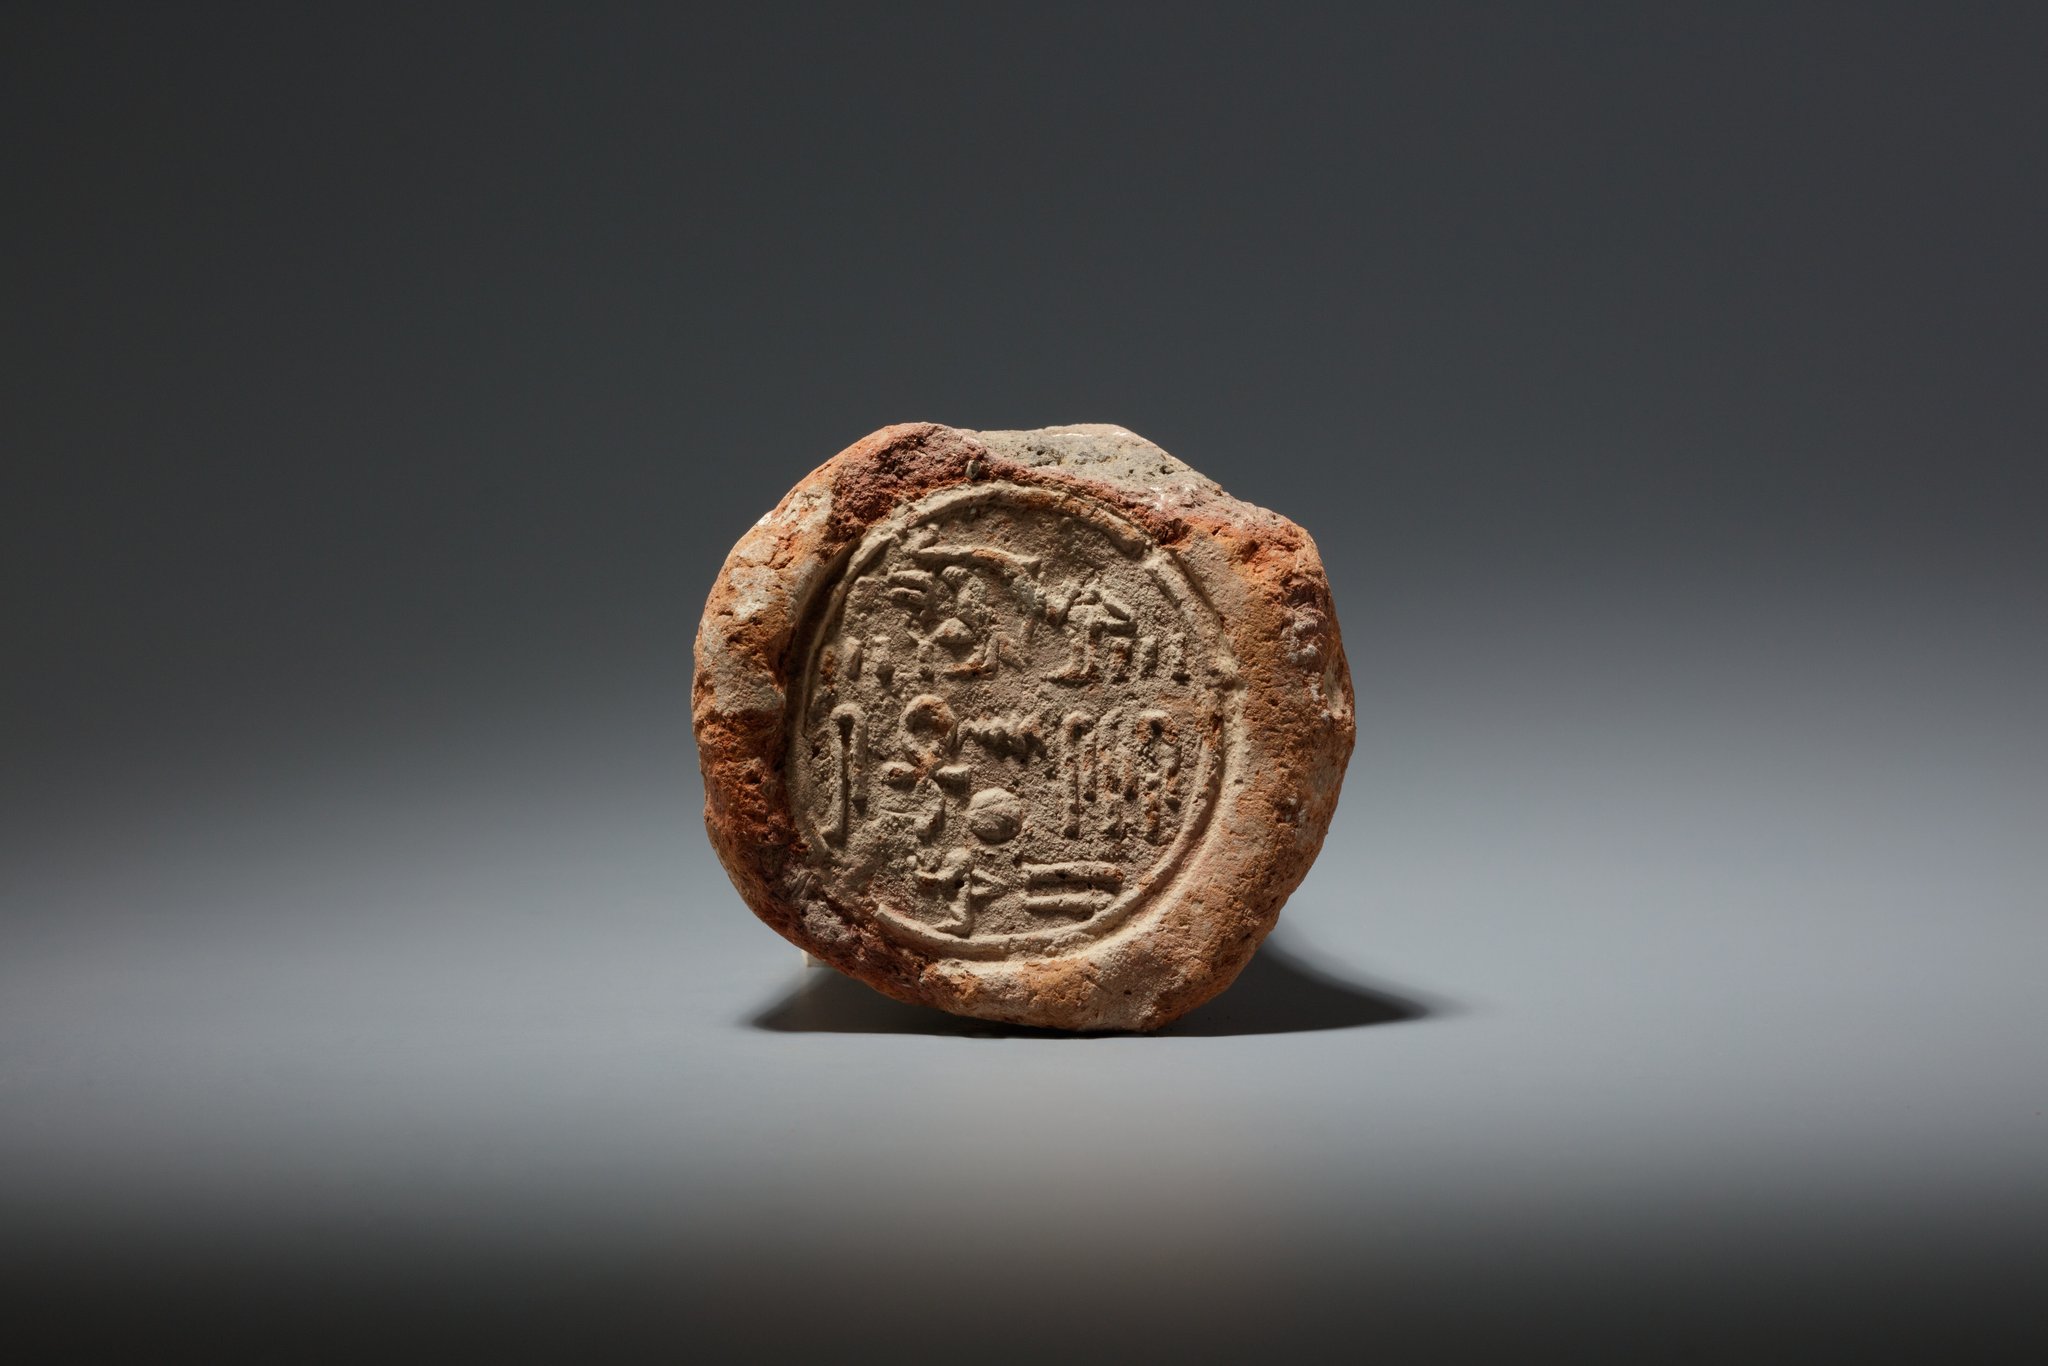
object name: cone, davy 512, su, overseer, sculptor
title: Funerary Cone of the Overseer of Sculptors Su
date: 1550-1295 BCE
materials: pottery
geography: egypt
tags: hieroglyphs